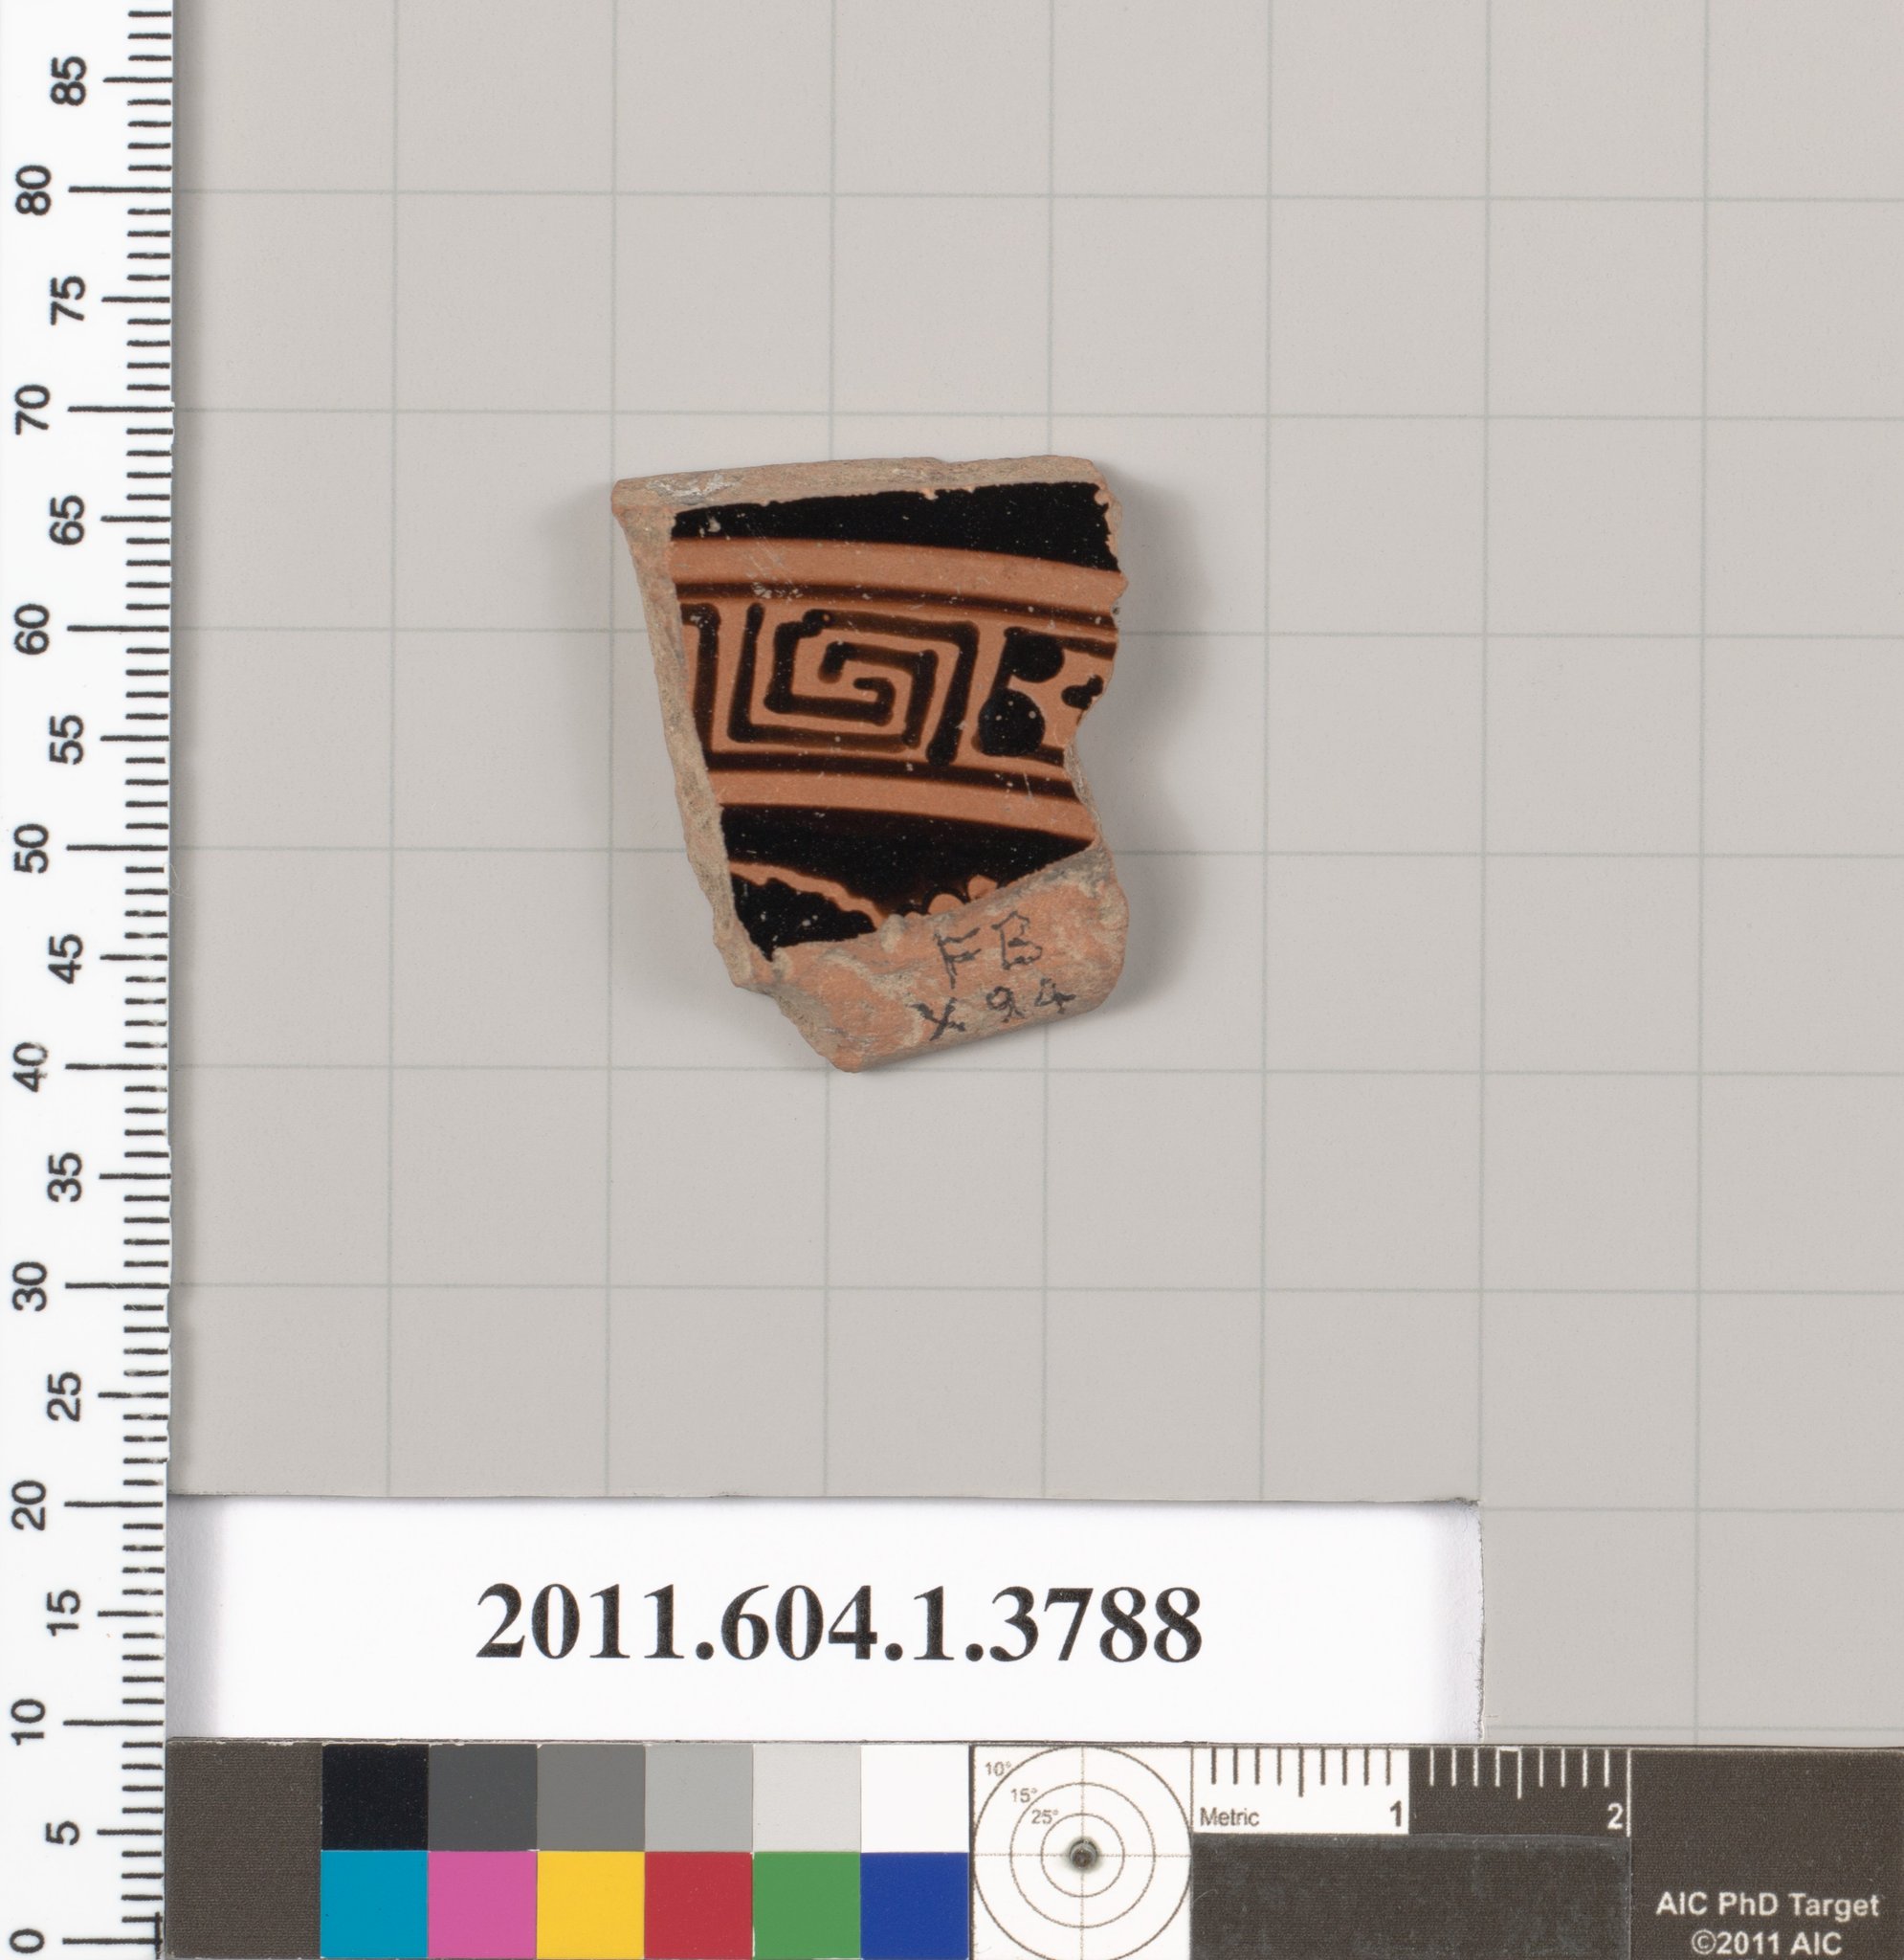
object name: kylix fragment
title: Terracotta fragment of a kylix (drinking cup)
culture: greek, attic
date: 490-470 BCE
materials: terracotta